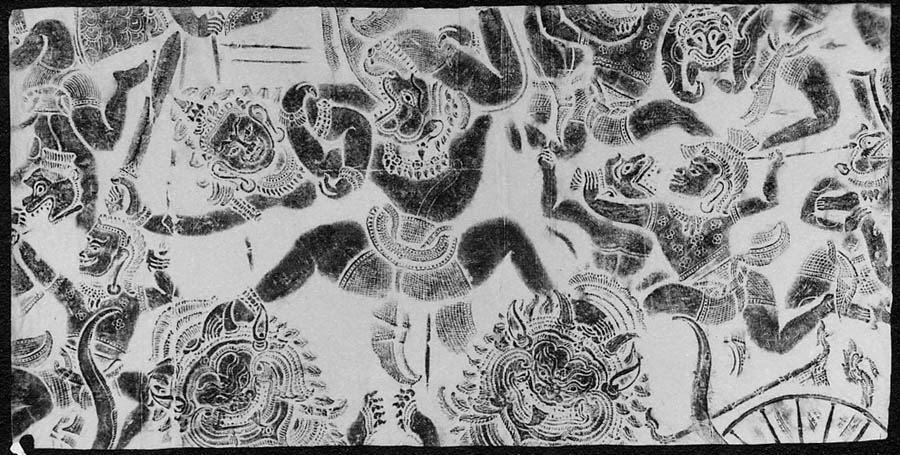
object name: rubbing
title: Rubbing of a Scene from the Ramayana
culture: cambodian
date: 1901-2000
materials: ink, paper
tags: human figures,battles